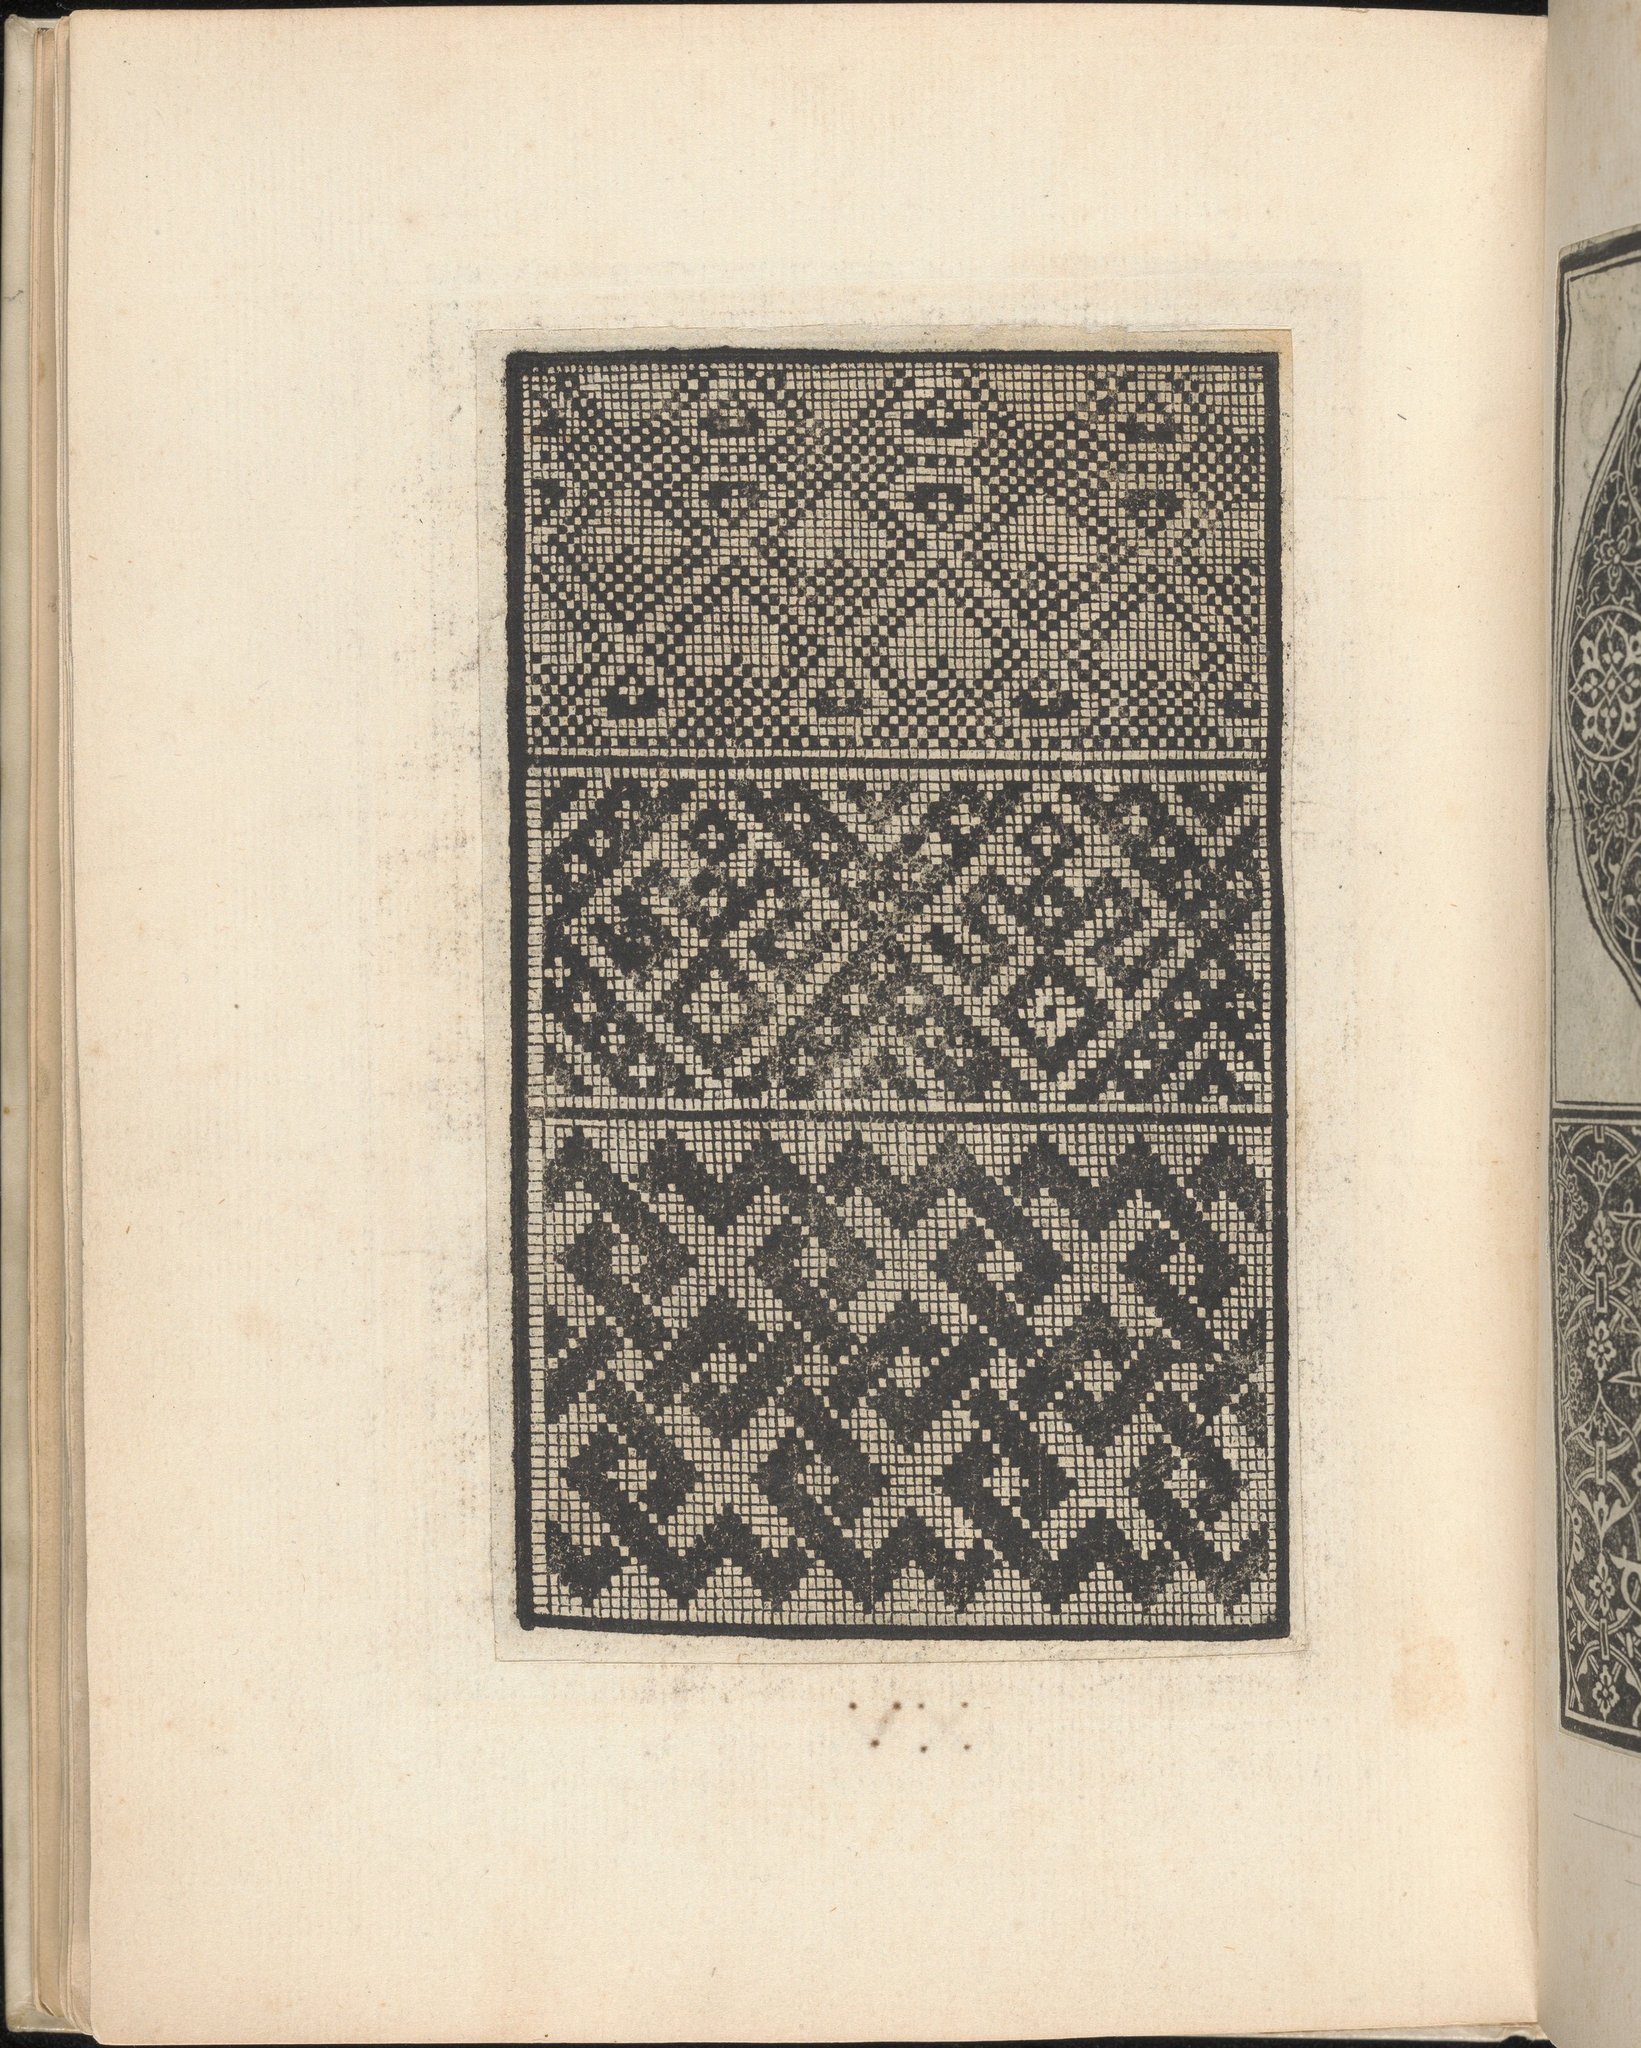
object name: book print ornament architecture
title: Esemplario di lavori, page 15 (recto)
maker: nicolò zoppino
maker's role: publisher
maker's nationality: italian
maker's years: 1478-1544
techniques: bookbinding, inlay, woodcut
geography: italy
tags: ornament